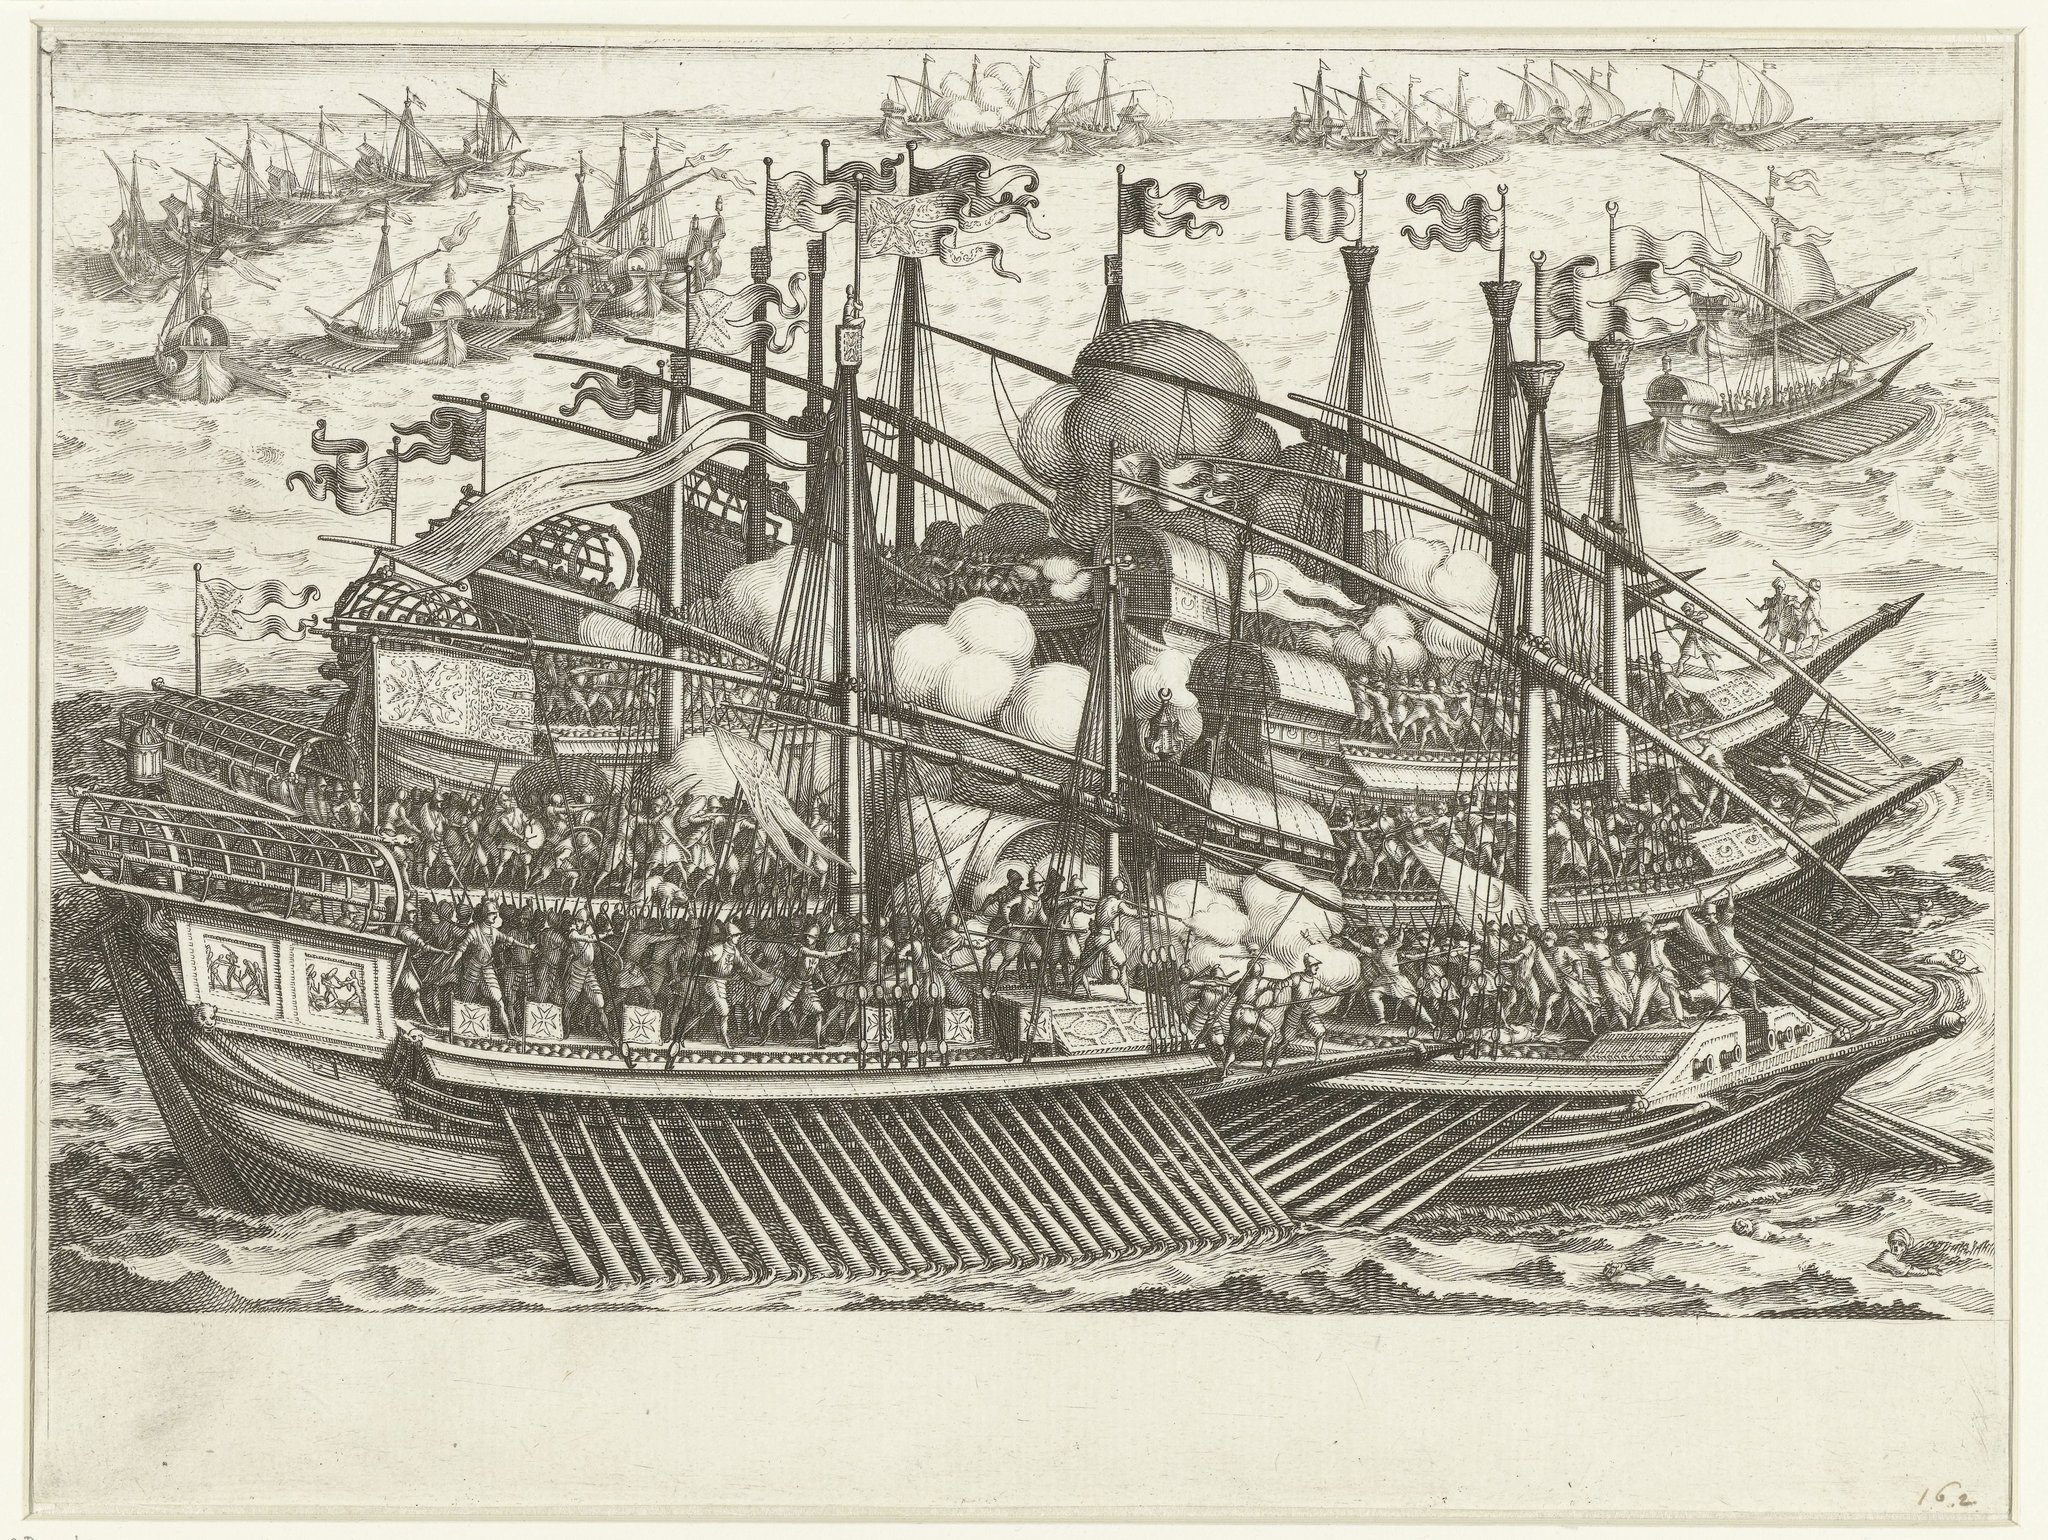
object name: print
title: Leven van Ferdinando I de' Medici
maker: jacques callot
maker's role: draughtsman, print maker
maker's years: 1592-1635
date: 1614-1620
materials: paper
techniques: engraving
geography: florence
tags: ferdinando i de' medici, asiatic races and peoples: turks, battle, warfare; military affairs (+ sailing-ships), ships (in general)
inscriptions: collector's mark: Lugt 240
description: Op de voorgrond worden een aantal Turkse schepen aangevallen door schepen van Ferdinando I de' Medici. Op de achtergrond ligt nog een heel aantal galeischepen en vinden nog twee gevechten tussen schepen plaats. Onder de voorstelling een lege marge. Deze prent is onderdeel van een serie van 16 prenten (plus 2 onvoltooide prenten) van het leven van Ferdinando I de' Medici, bedoeld geweest als aanvulling op een reeds bestaande reeks illustraties van de geschiedenis van de Medicis.